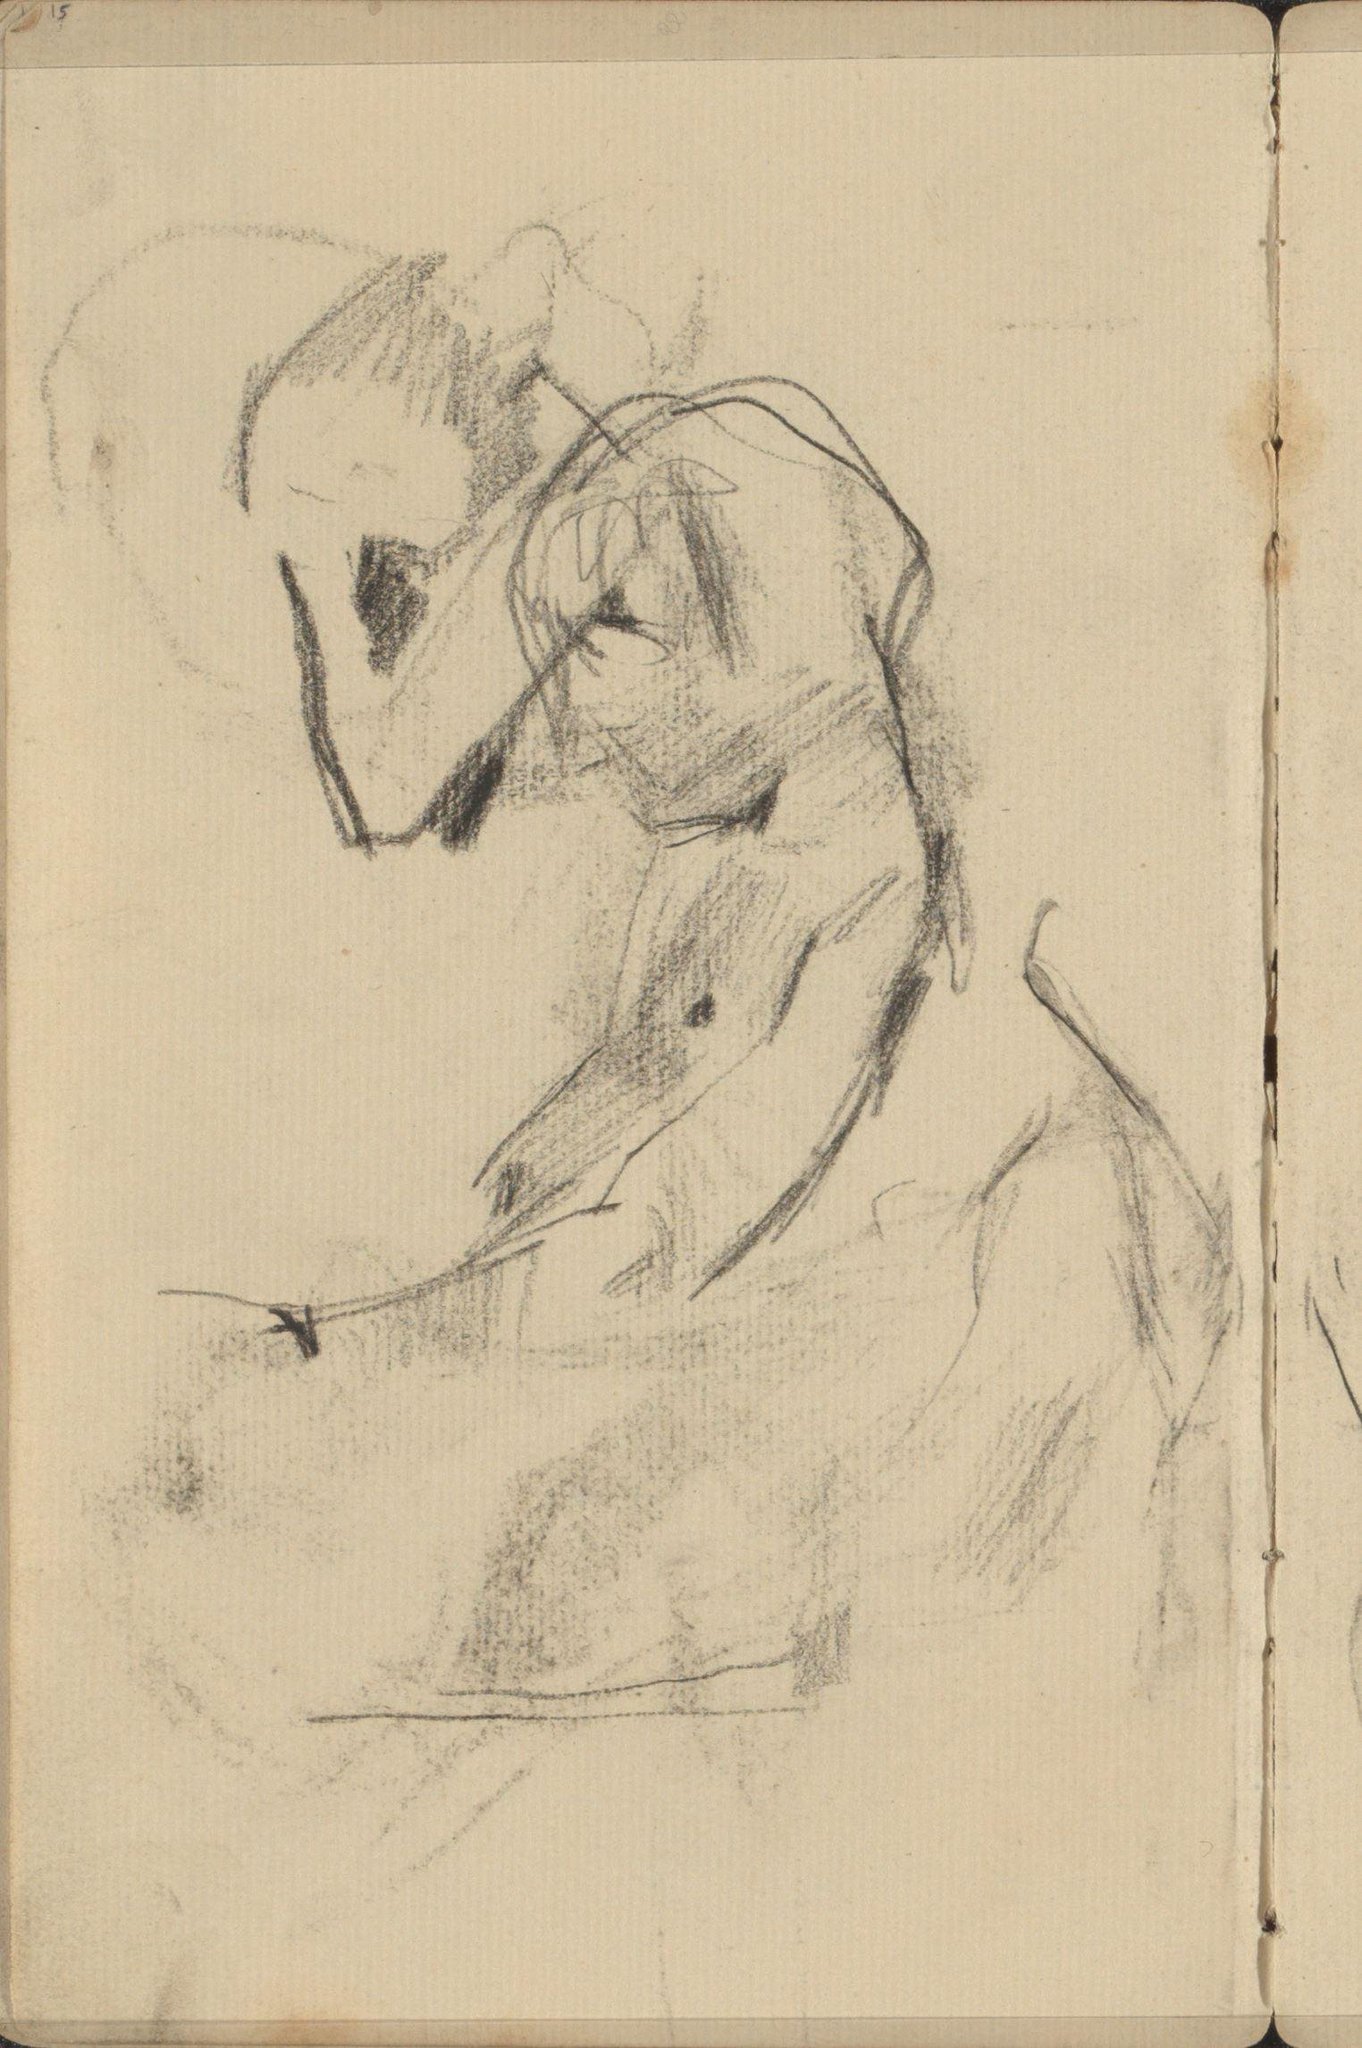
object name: sketchbook leaf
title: Zittende figuur en een dierenkop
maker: george hendrik breitner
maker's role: draughtsman, painter, print maker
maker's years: 1857-1923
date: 1880-1882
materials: chalk, paper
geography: the hague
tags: animals, sitting figure (+ sideview, profile)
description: Pagina 15 uit een schetsboek met 19 bladen.